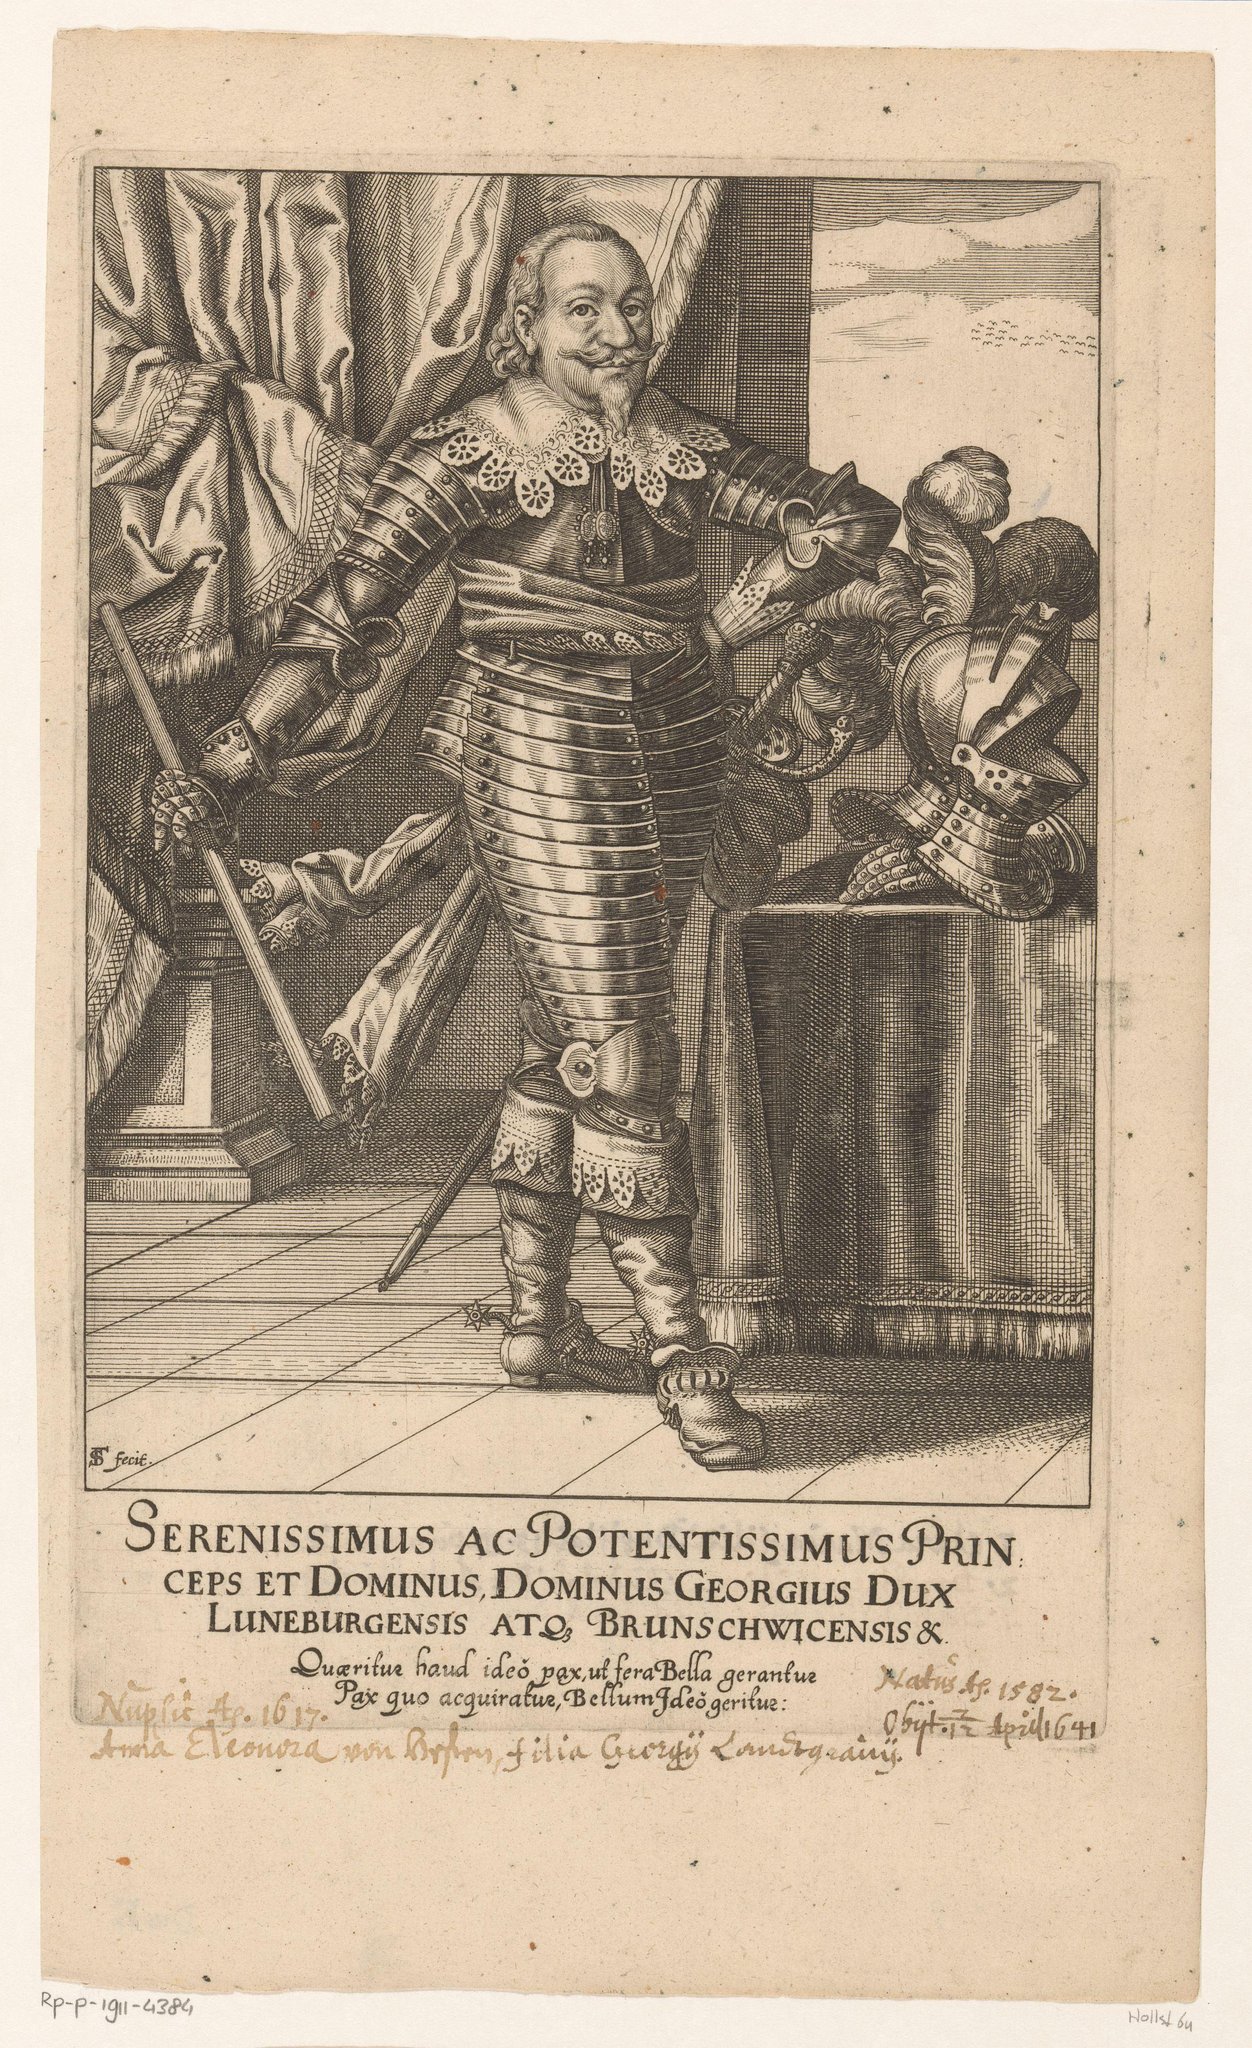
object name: print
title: Portret van Georg von Braunschweig-Lüneburg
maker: sebastian furck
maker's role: print maker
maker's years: 1600-1655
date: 1610-1641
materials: paper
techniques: engraving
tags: helmet, armour, historical persons, baton of general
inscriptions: inscription, collector's mark: Lugt 2228